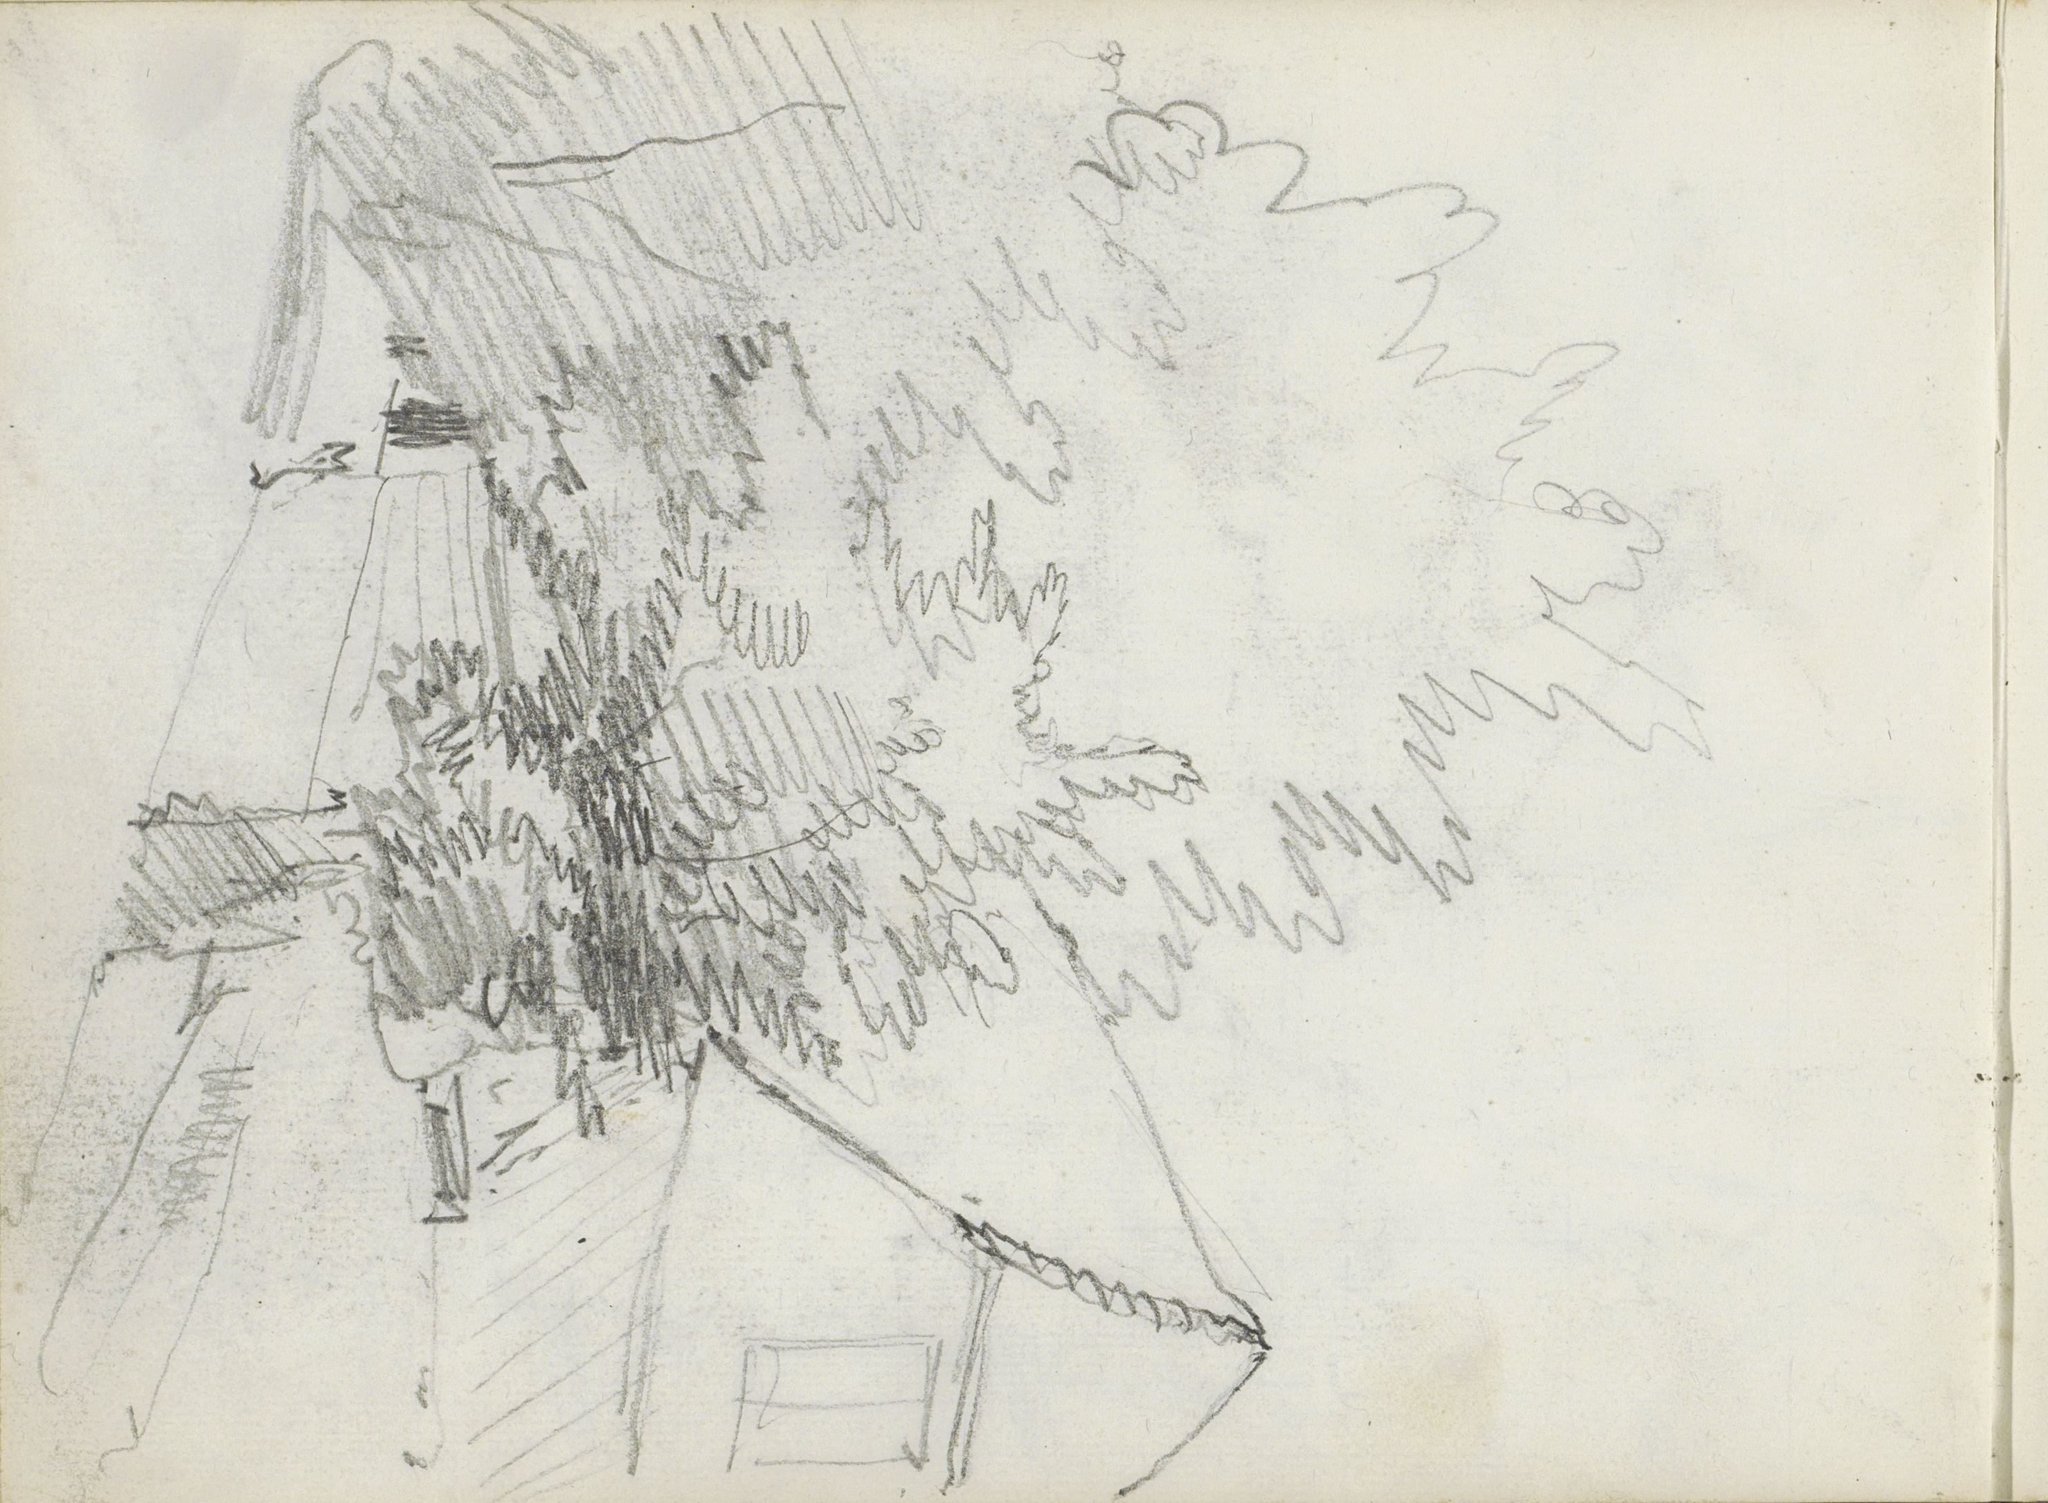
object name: sketchbook leaf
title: Bomen naast een huis met een puntdak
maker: willem koekkoek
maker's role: draughtsman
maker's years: 1839-1895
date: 1849-1895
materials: paper, pencil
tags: cottage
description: Pagina 5 verso uit een schetsboek met 26 bladen.